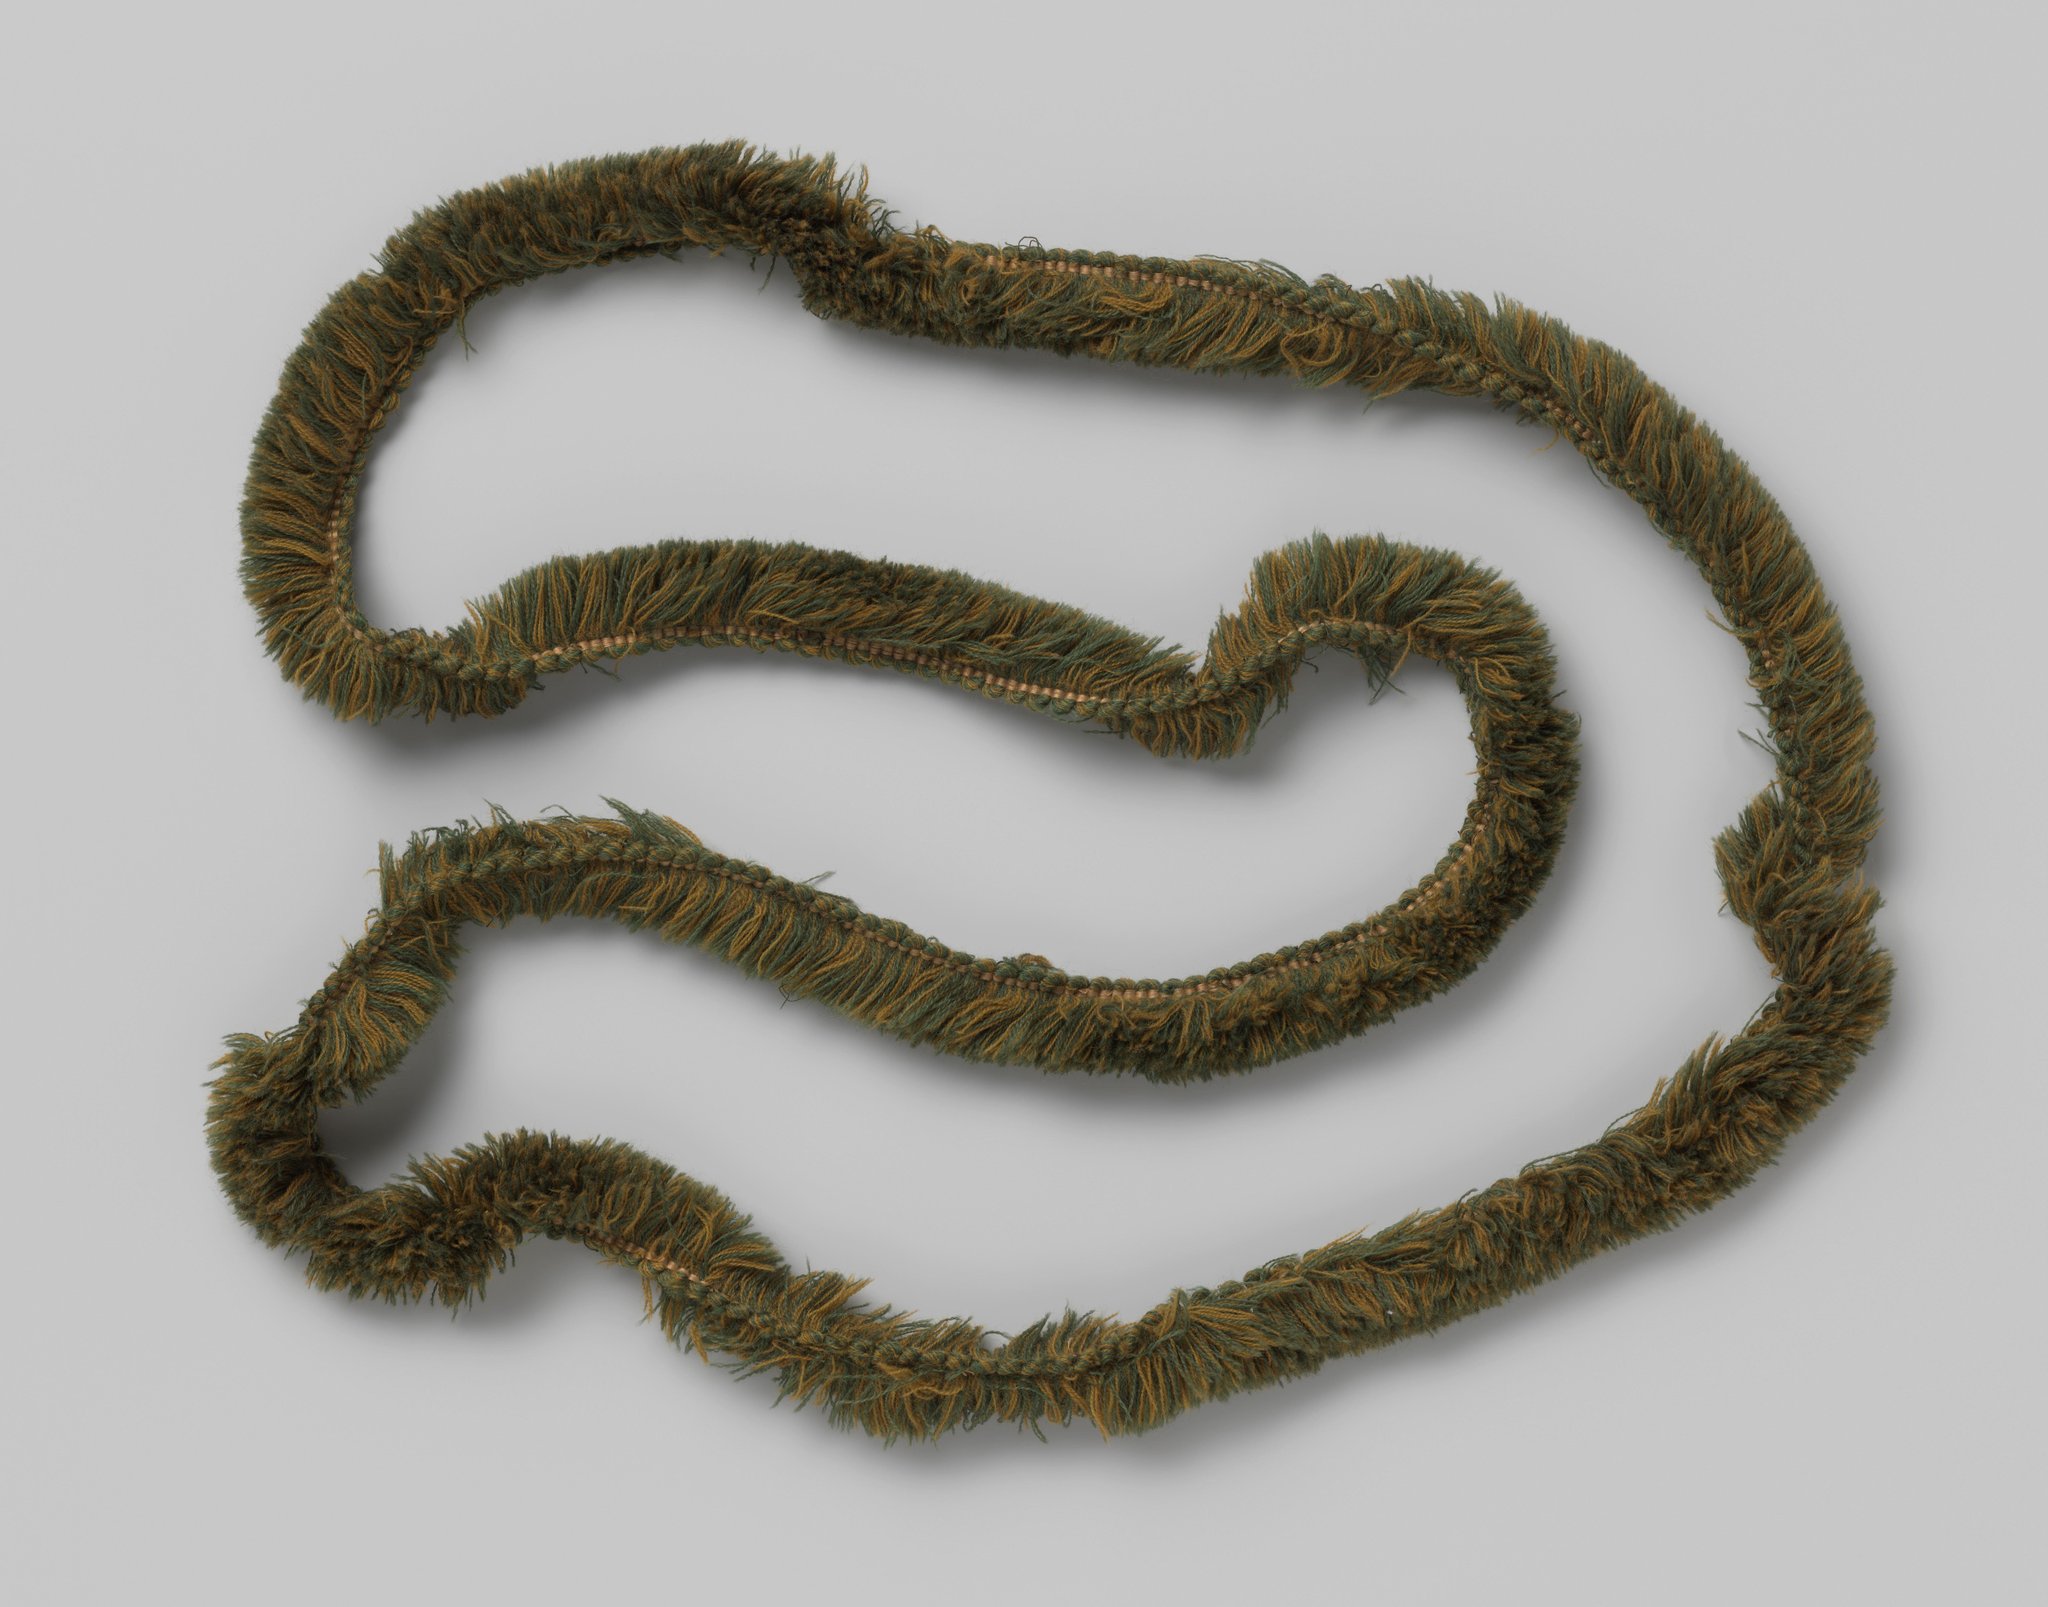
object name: fringe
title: Franje van een kussen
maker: Anonymous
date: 1632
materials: wool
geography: northern netherlands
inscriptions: date: ‘AN NO // 1732’, inscription: ‘RYP’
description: Franje horend bij een kussenblad van een magistratenkussen van tapijtweefsel met het gemeentewapen van de Rijp. De uiteinden zijn aan elkaar genaaid.